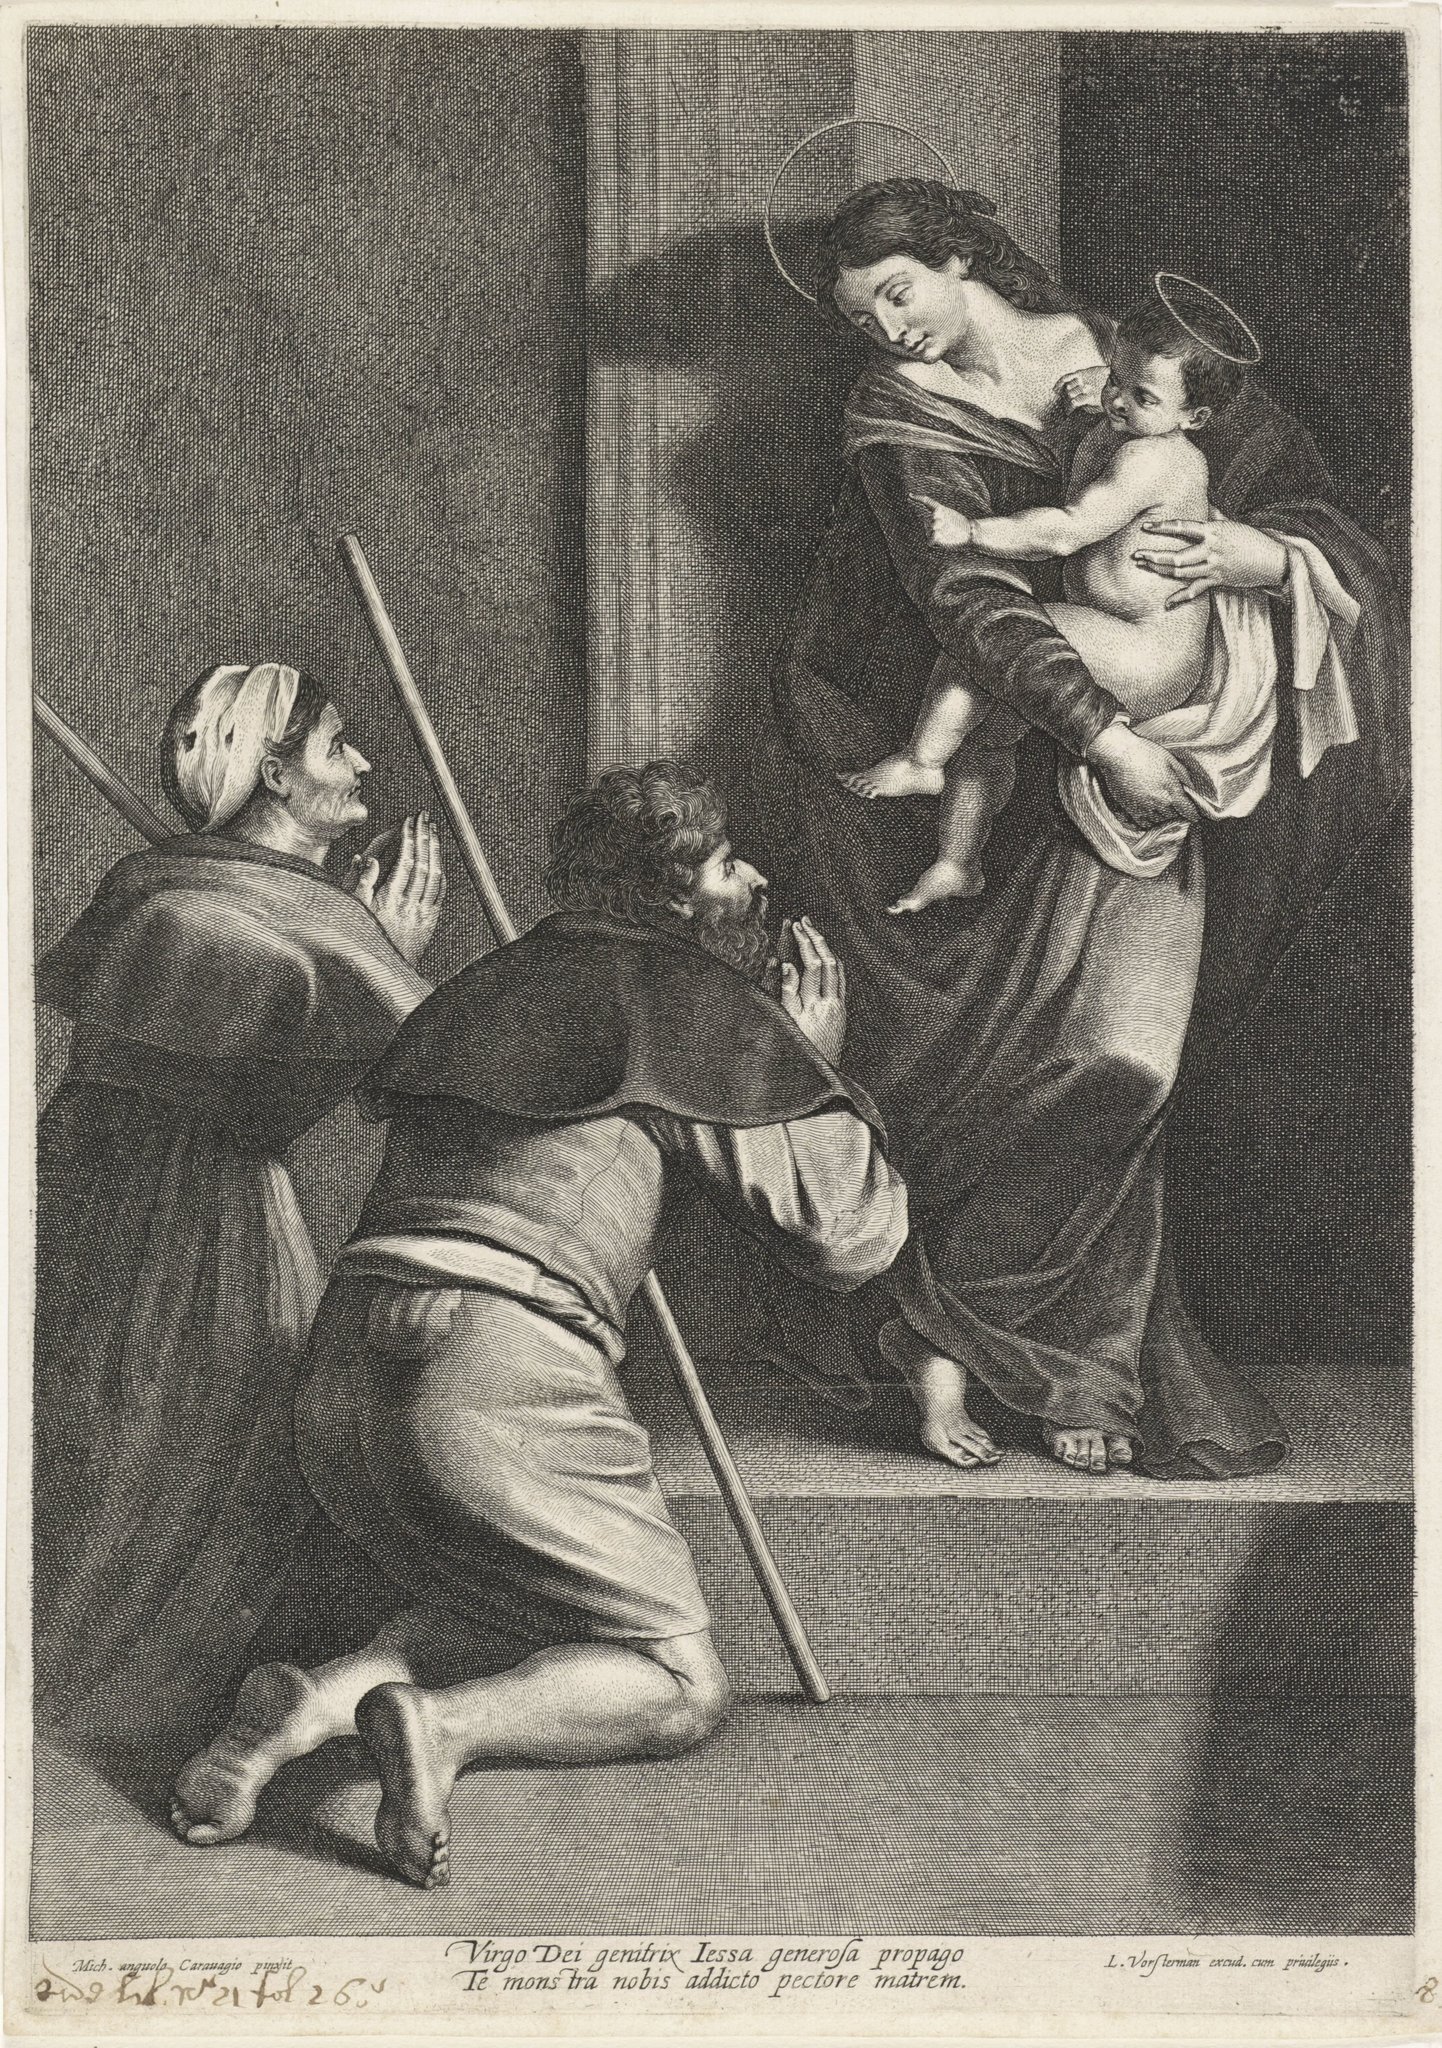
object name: print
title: Madonna van Loretto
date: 1619-1675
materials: paper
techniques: engraving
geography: antwerp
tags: mary standing (or half-length), the christ-child in front of her, close to her bosom; standing (+ donor(s), supplicant(s), whether or not with patron saint(s))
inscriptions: inscription: ‘[...] 26’, collector's mark: Lugt 10, collector's mark: Lugt 240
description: Twee smekelingen aanbidden Maria met Kind, staand op een verhoging.